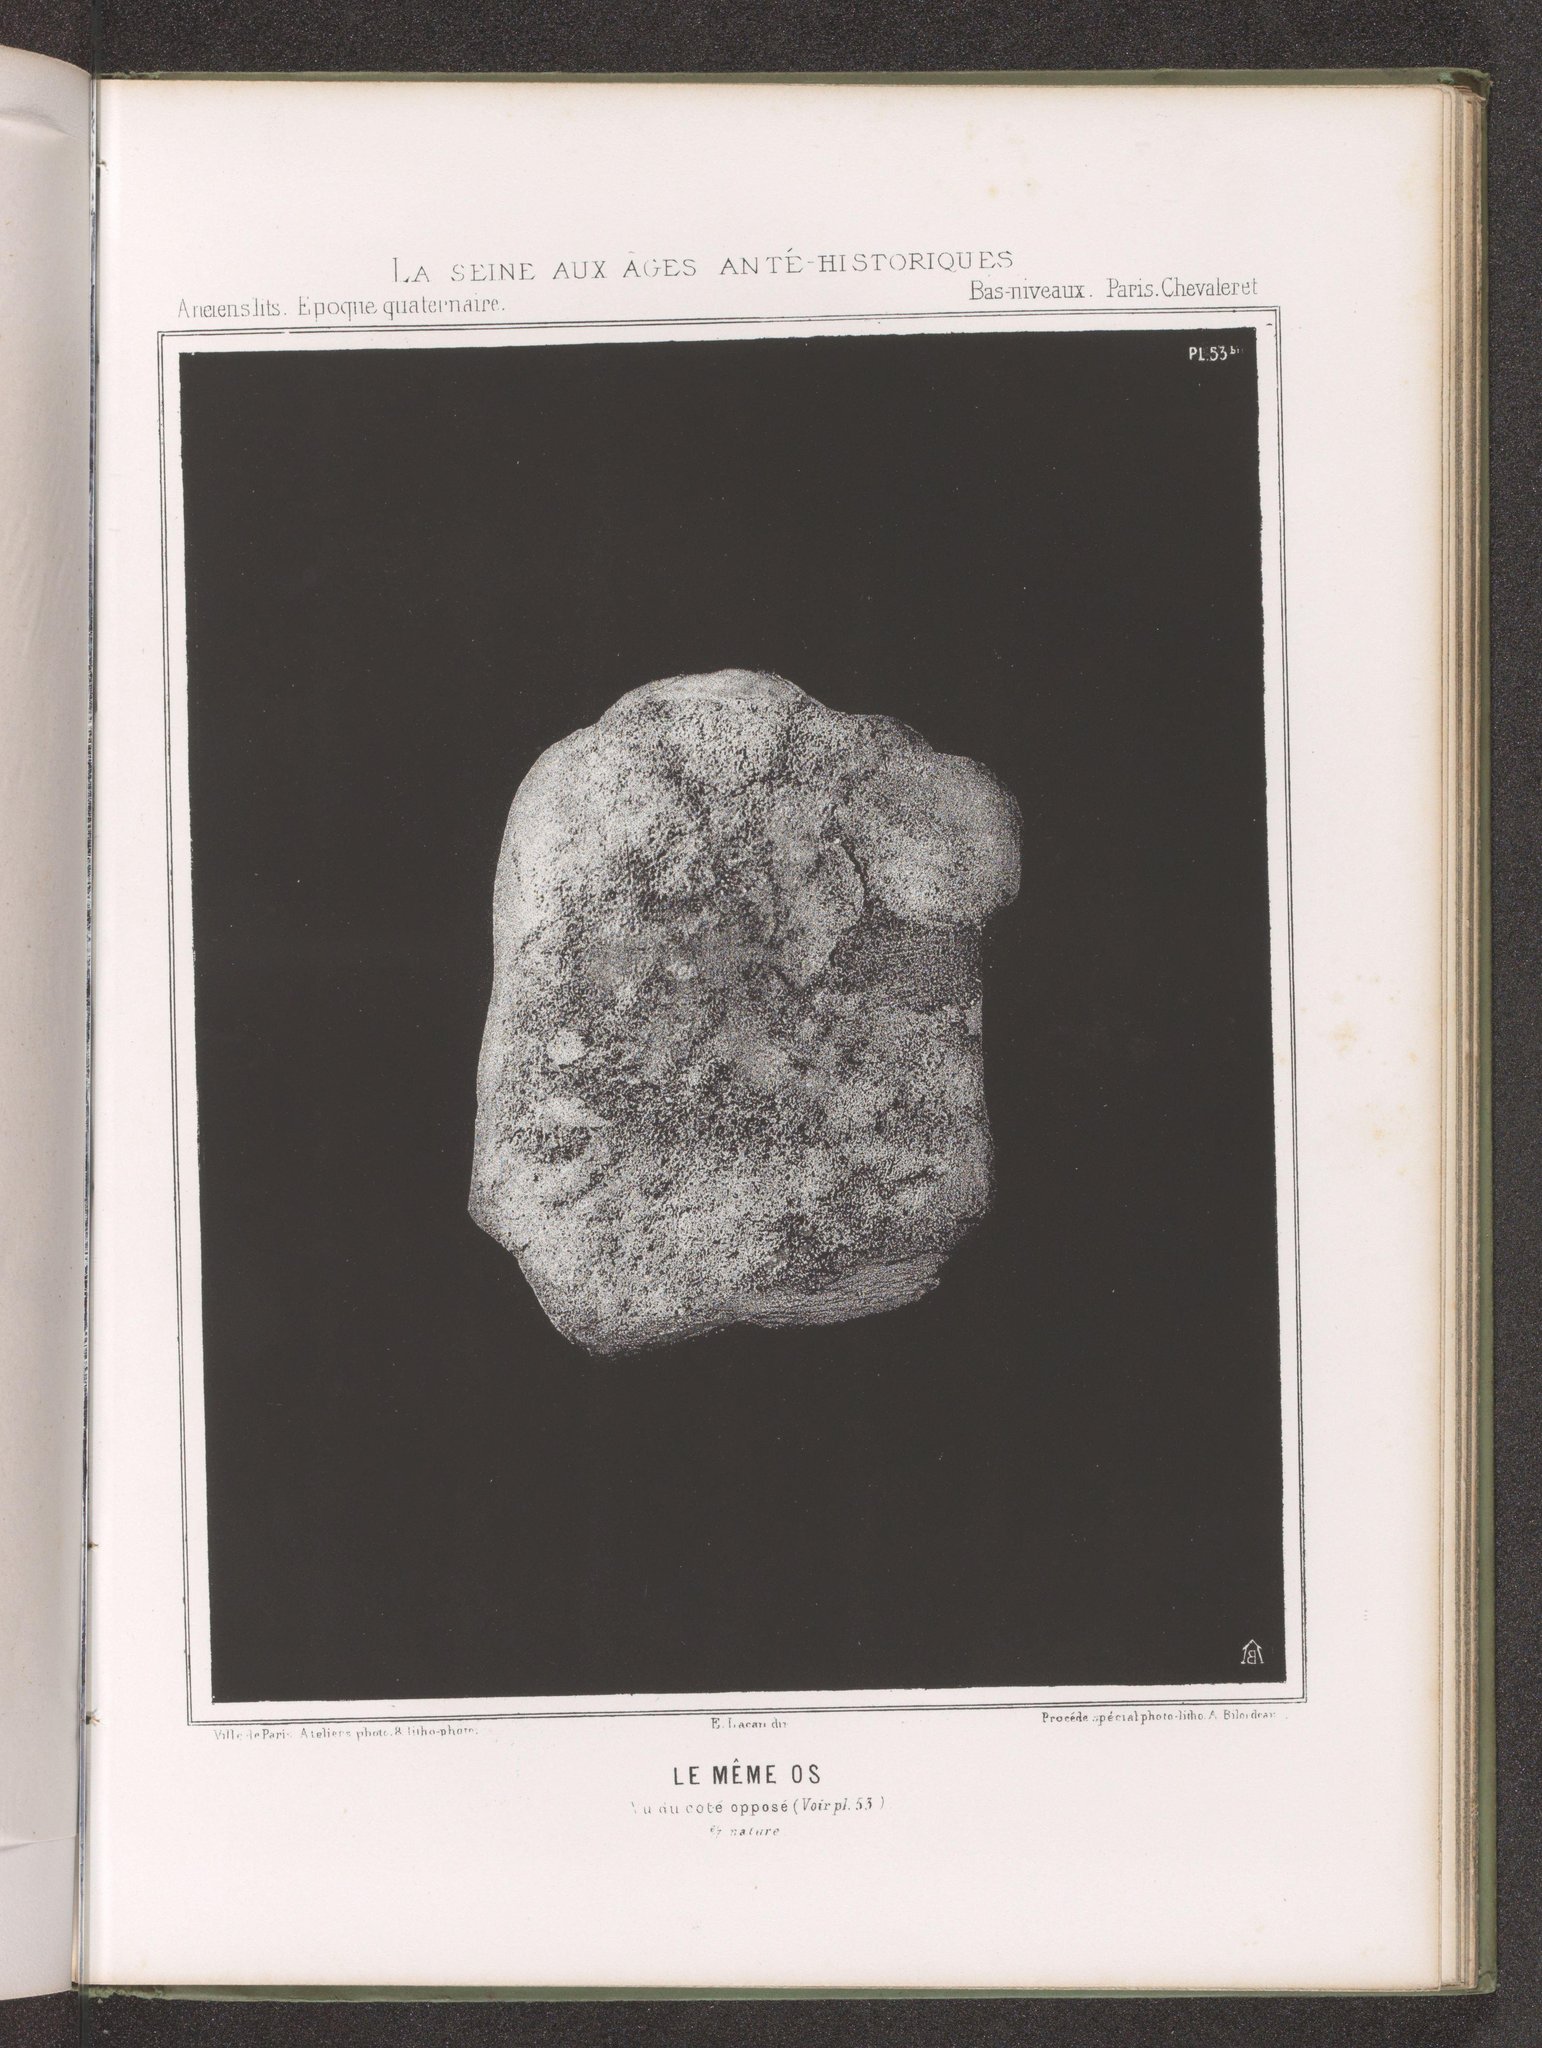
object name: photomechanical print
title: LE MÊME OS (Vu au coté opposé (Voir pl. 53) 6/7 nature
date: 1860-1869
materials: paper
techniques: photolithography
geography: paris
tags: animals (+ skeleton of an animal), palaeontology, france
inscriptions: inscription: ‘Ville de Paris. Ateliers photo. & litho-photo. E. Lacan dir. Procédé spécial photo-litho A. Bilordeaux.’, monogram: ‘AB’, number: ‘Pl. 53bis’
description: Voor plek prent in boek: zie nummer onder 'Opschriften / Merken'.